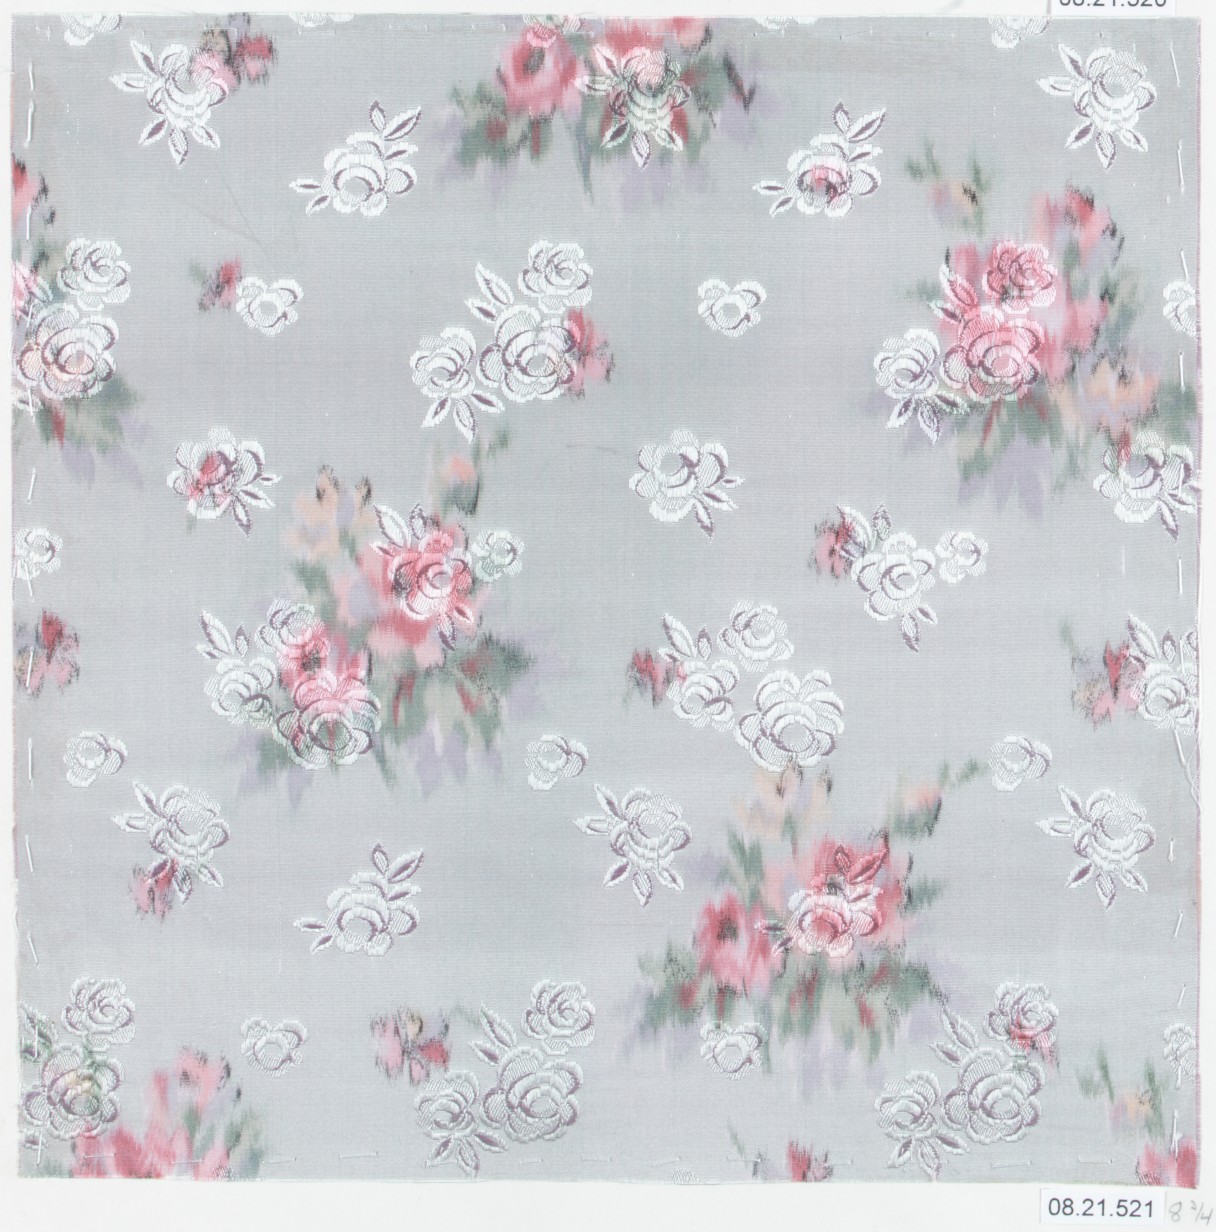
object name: textile sample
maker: Anonymous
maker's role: designer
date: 1900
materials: silk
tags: flowers